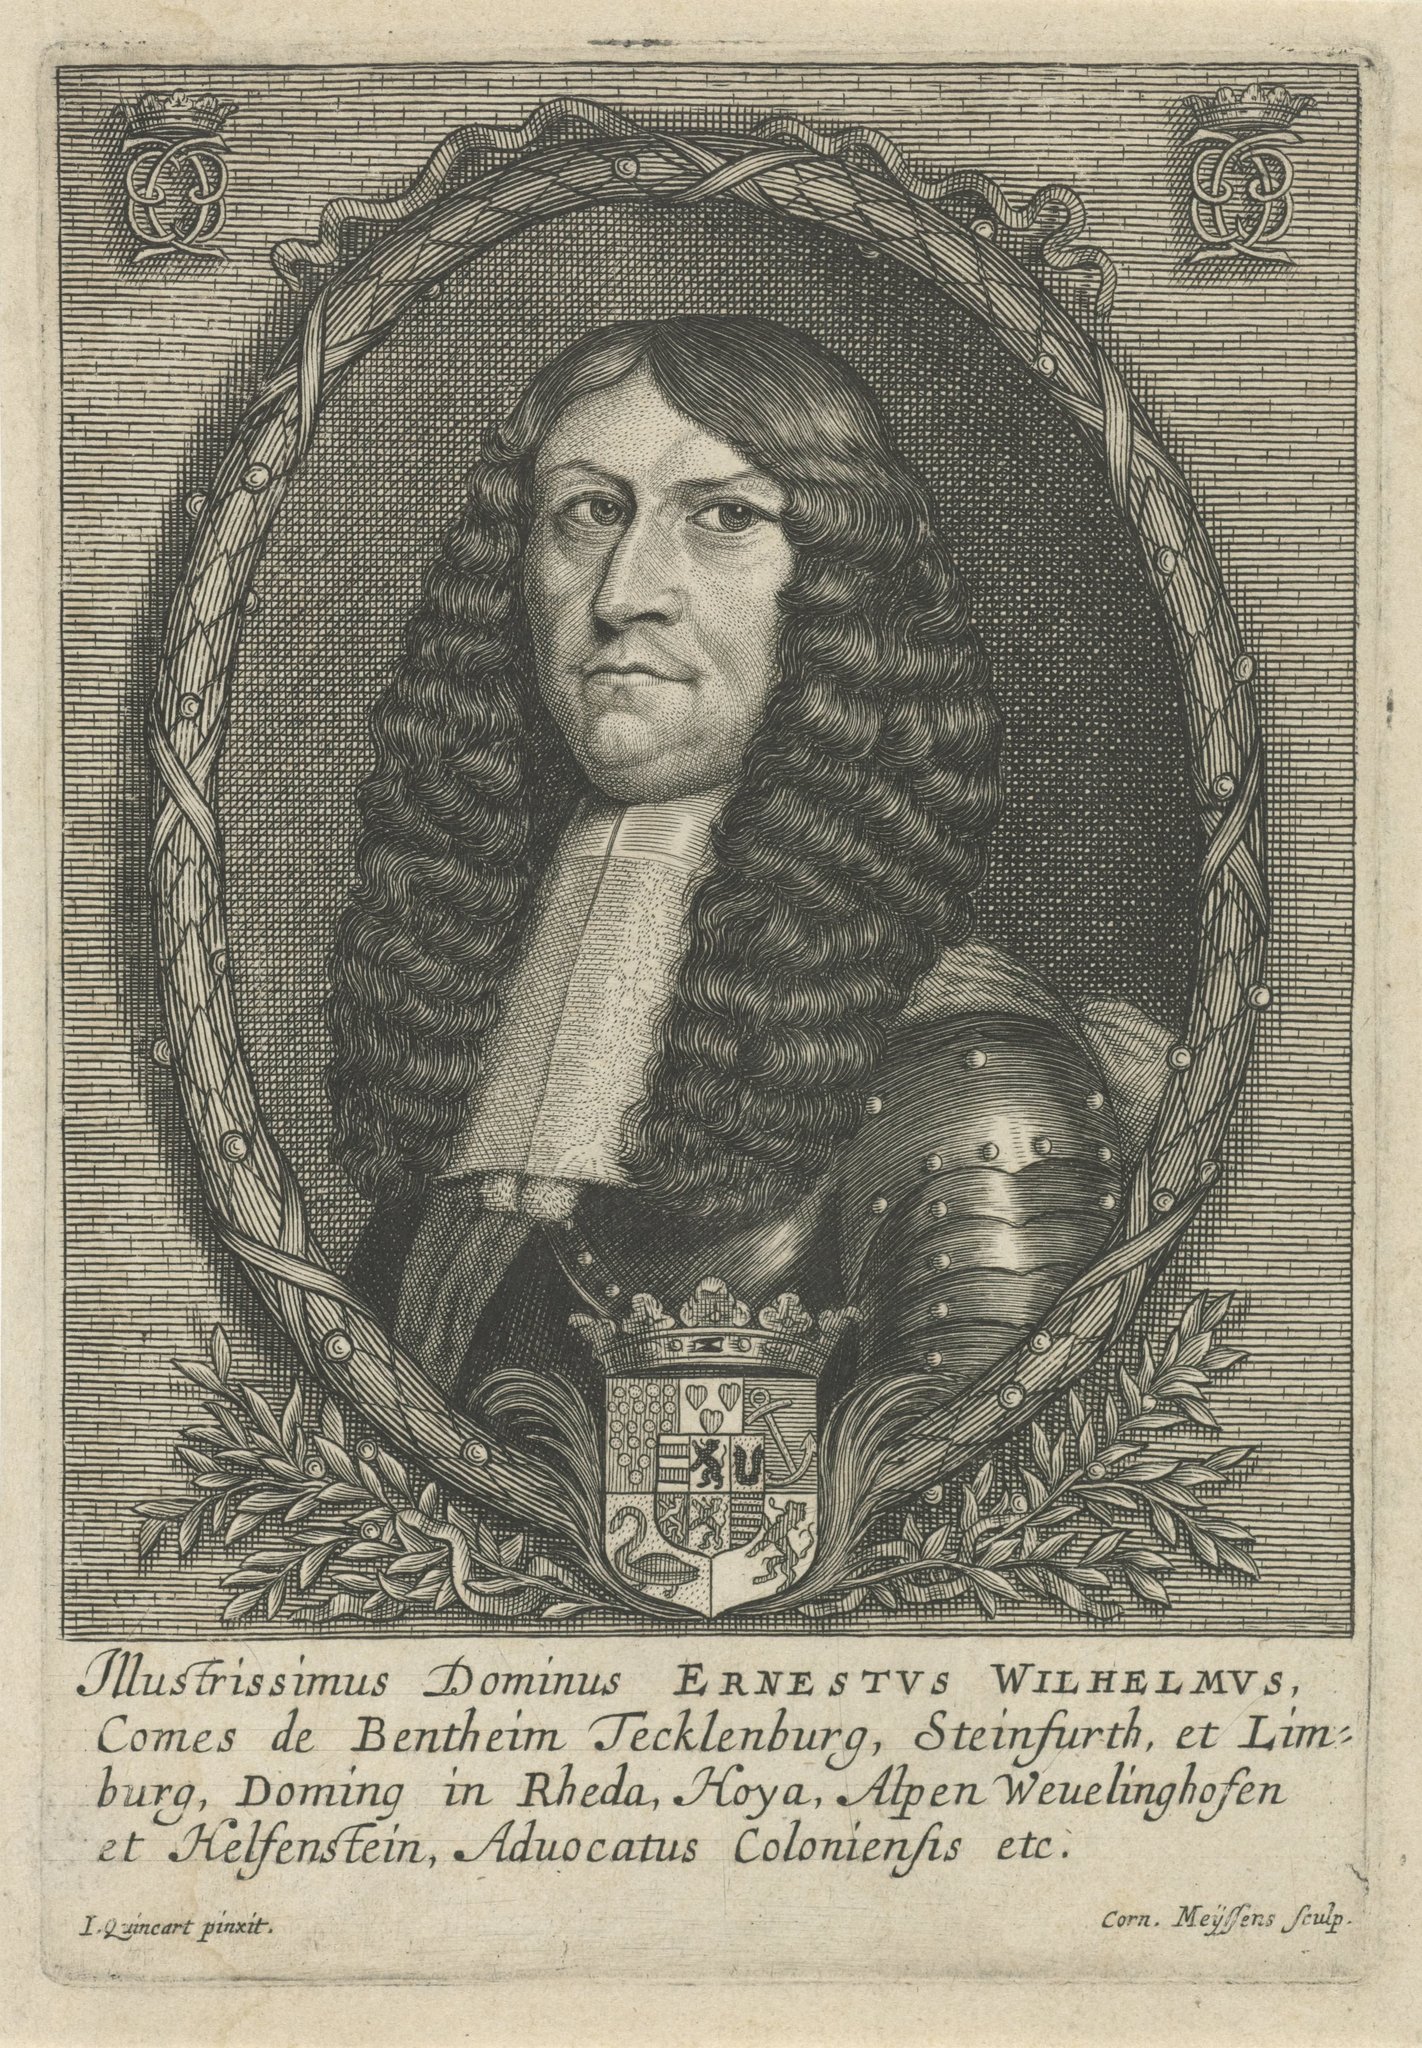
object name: print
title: Portret van Ernst Willem graaf van Bentheim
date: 1650-1693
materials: paper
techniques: engraving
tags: ernst willem graaf van bentheim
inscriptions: collector's mark: Lugt 964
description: Portret van Ernst Willem graaf van Bentheim. Midden onder in de lijst zijn wapenschild. Onderaan in de marge een vierregelige tekst in het Latijn.